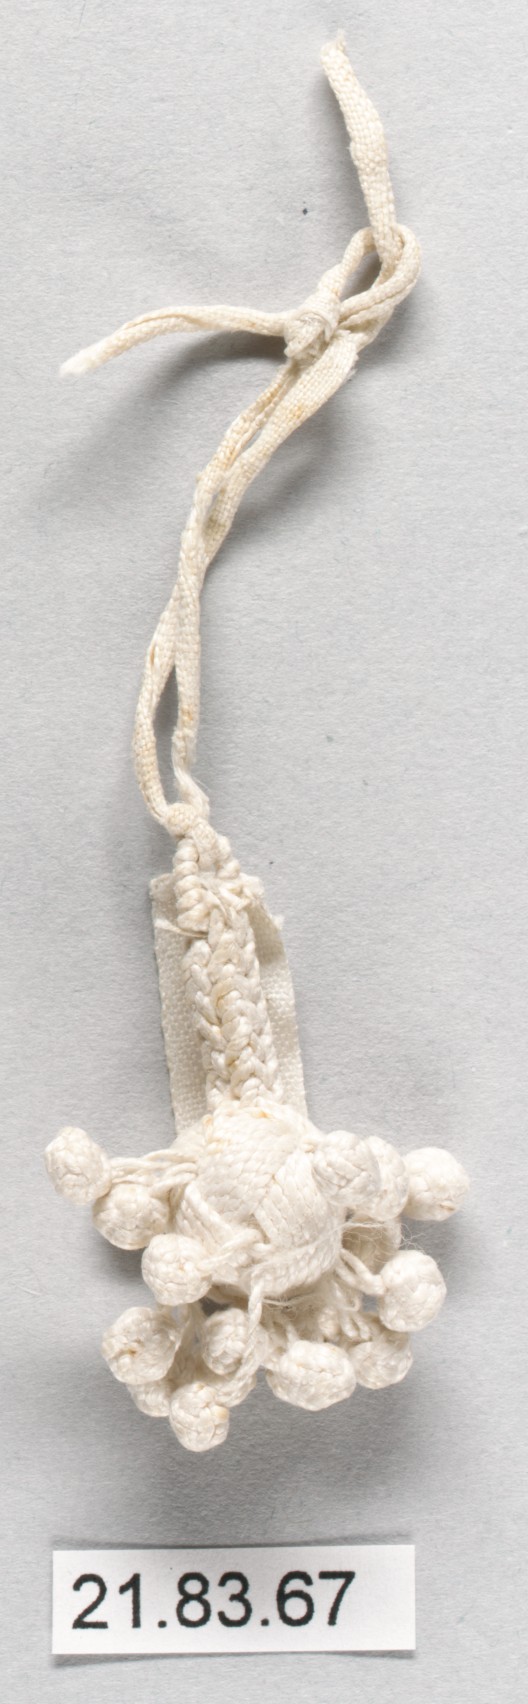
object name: tassel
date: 1601-1700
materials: linen